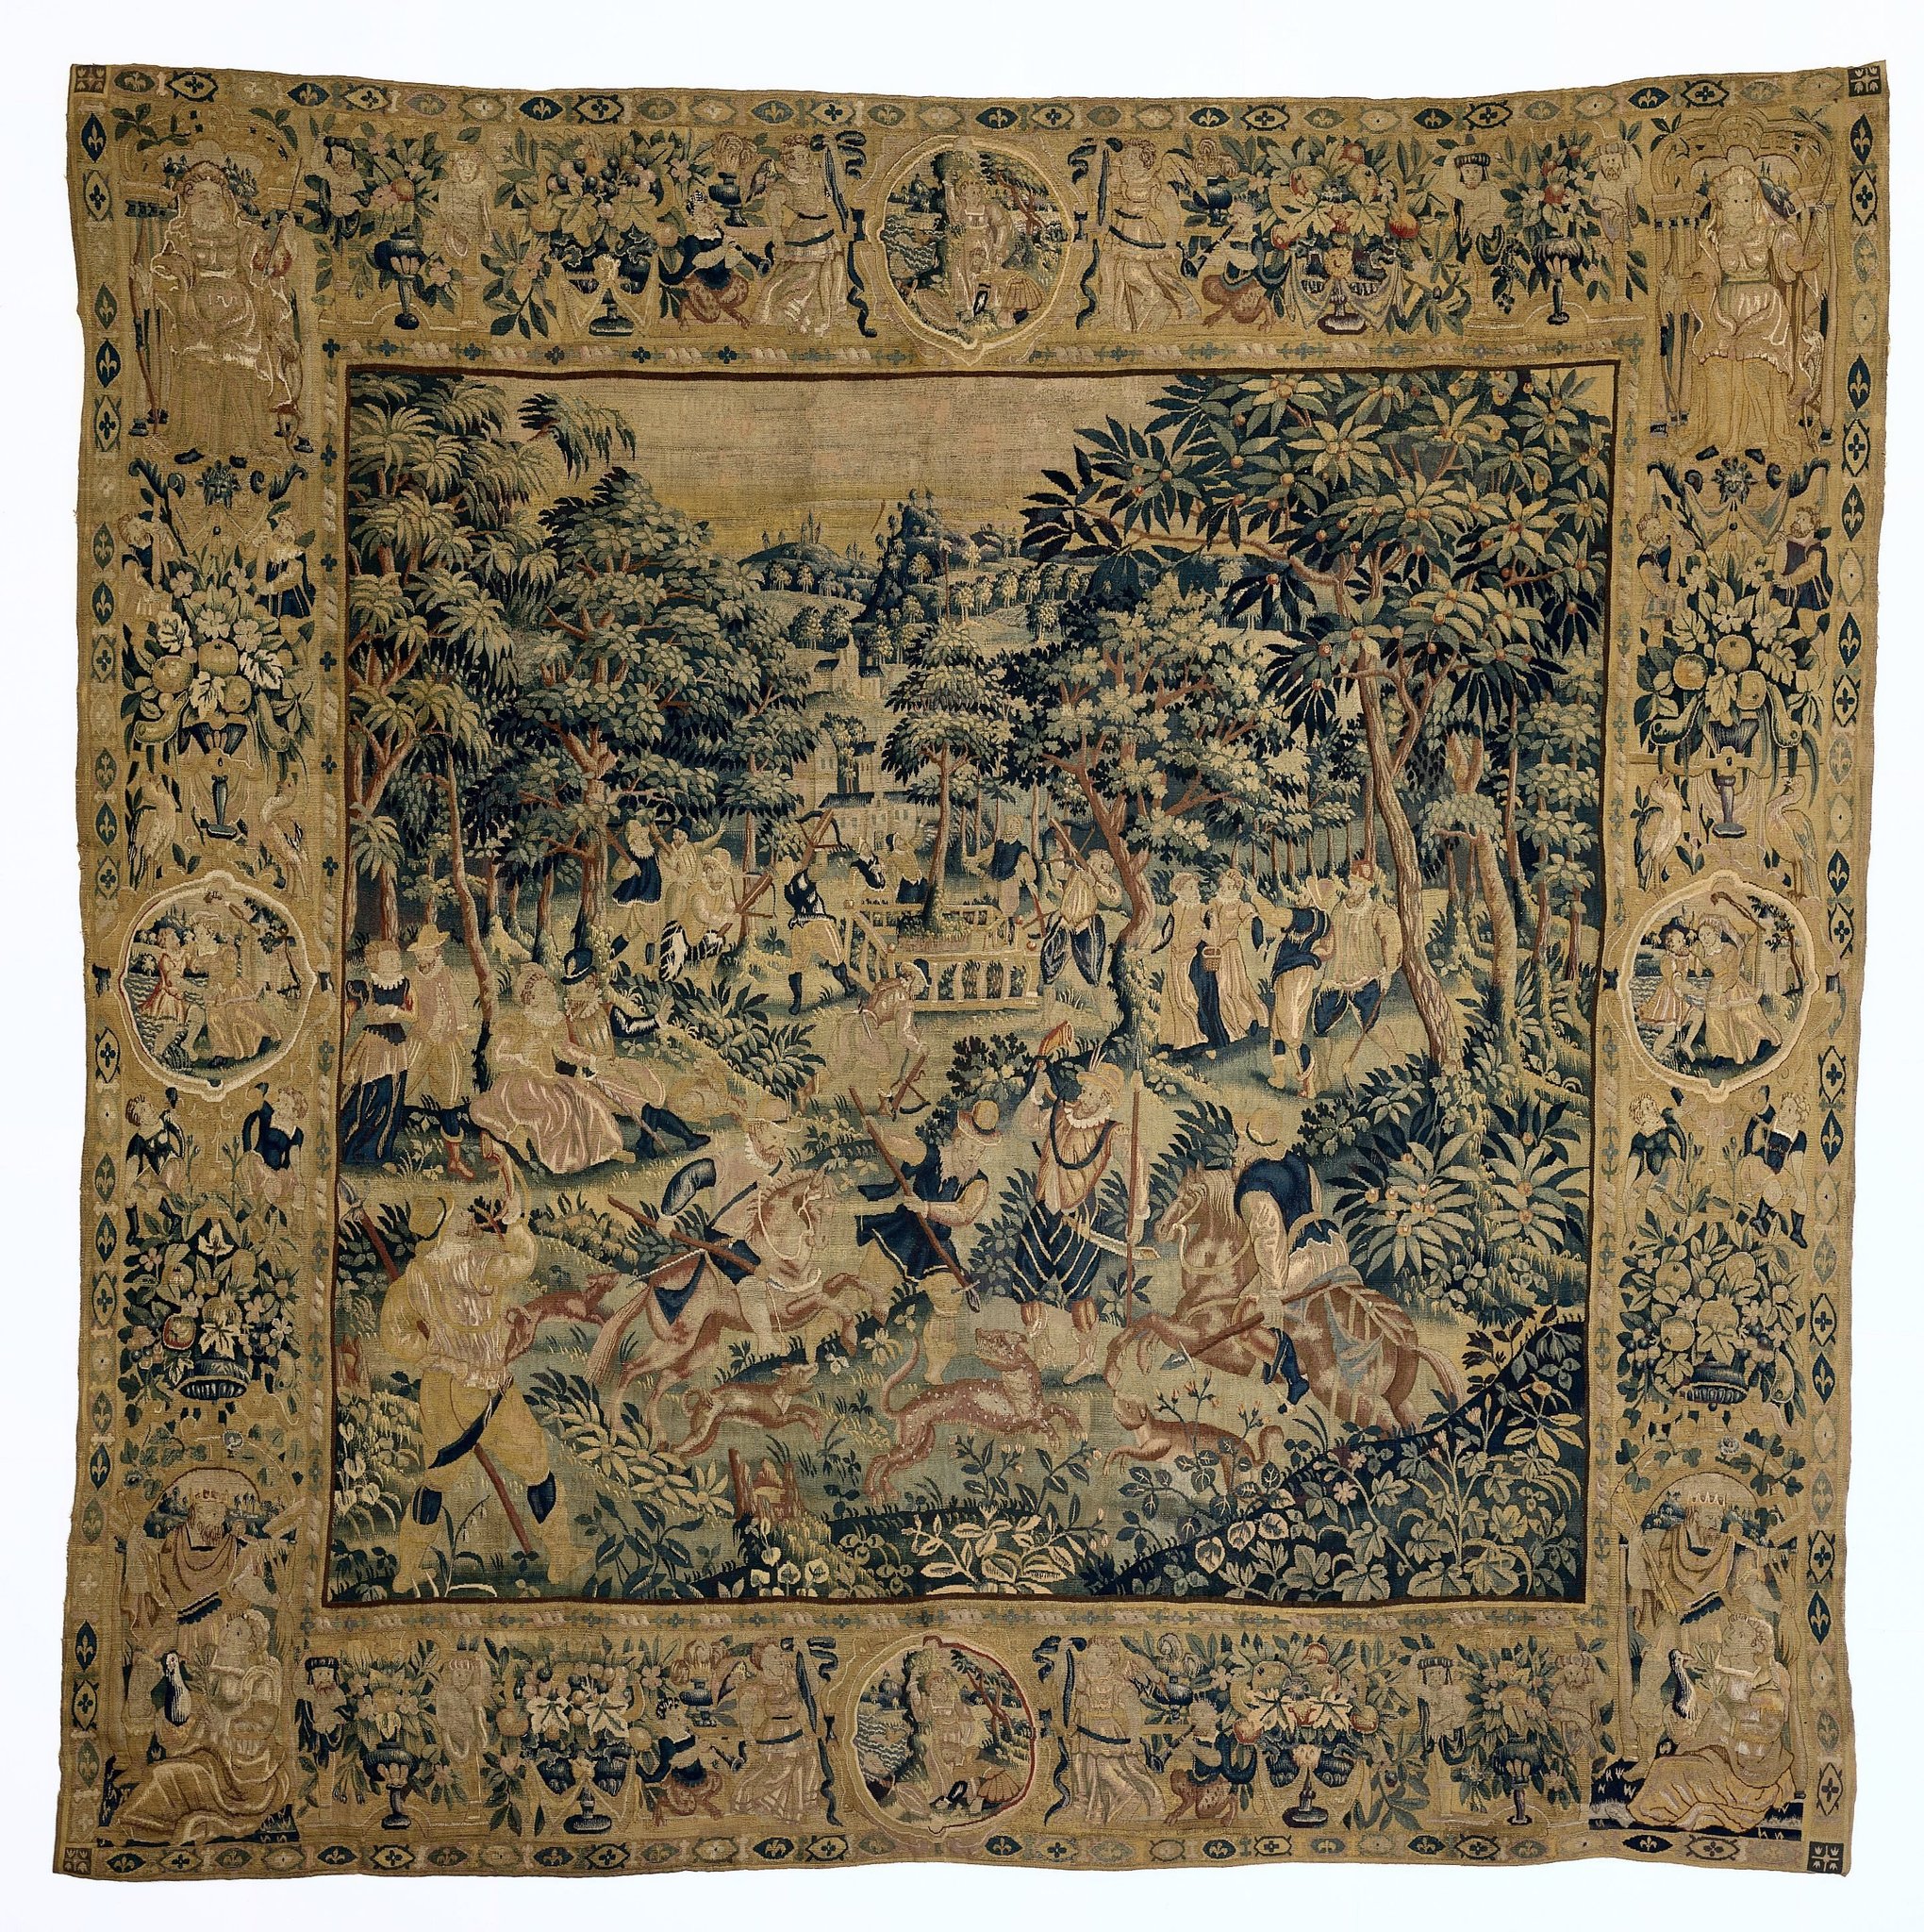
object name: verdure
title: Landschapsverdure met jachtscènes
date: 1575-1600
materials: silk, wool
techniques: tapestry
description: Wandtapijt met jachttafereel. In een boslandschap met open plek zijn jagers bezig met het vogelschieten, terwijl op de voorgrond een panter (?) door jagers en honden wordt opgejaagd. Randen met grotesken en cartouches.